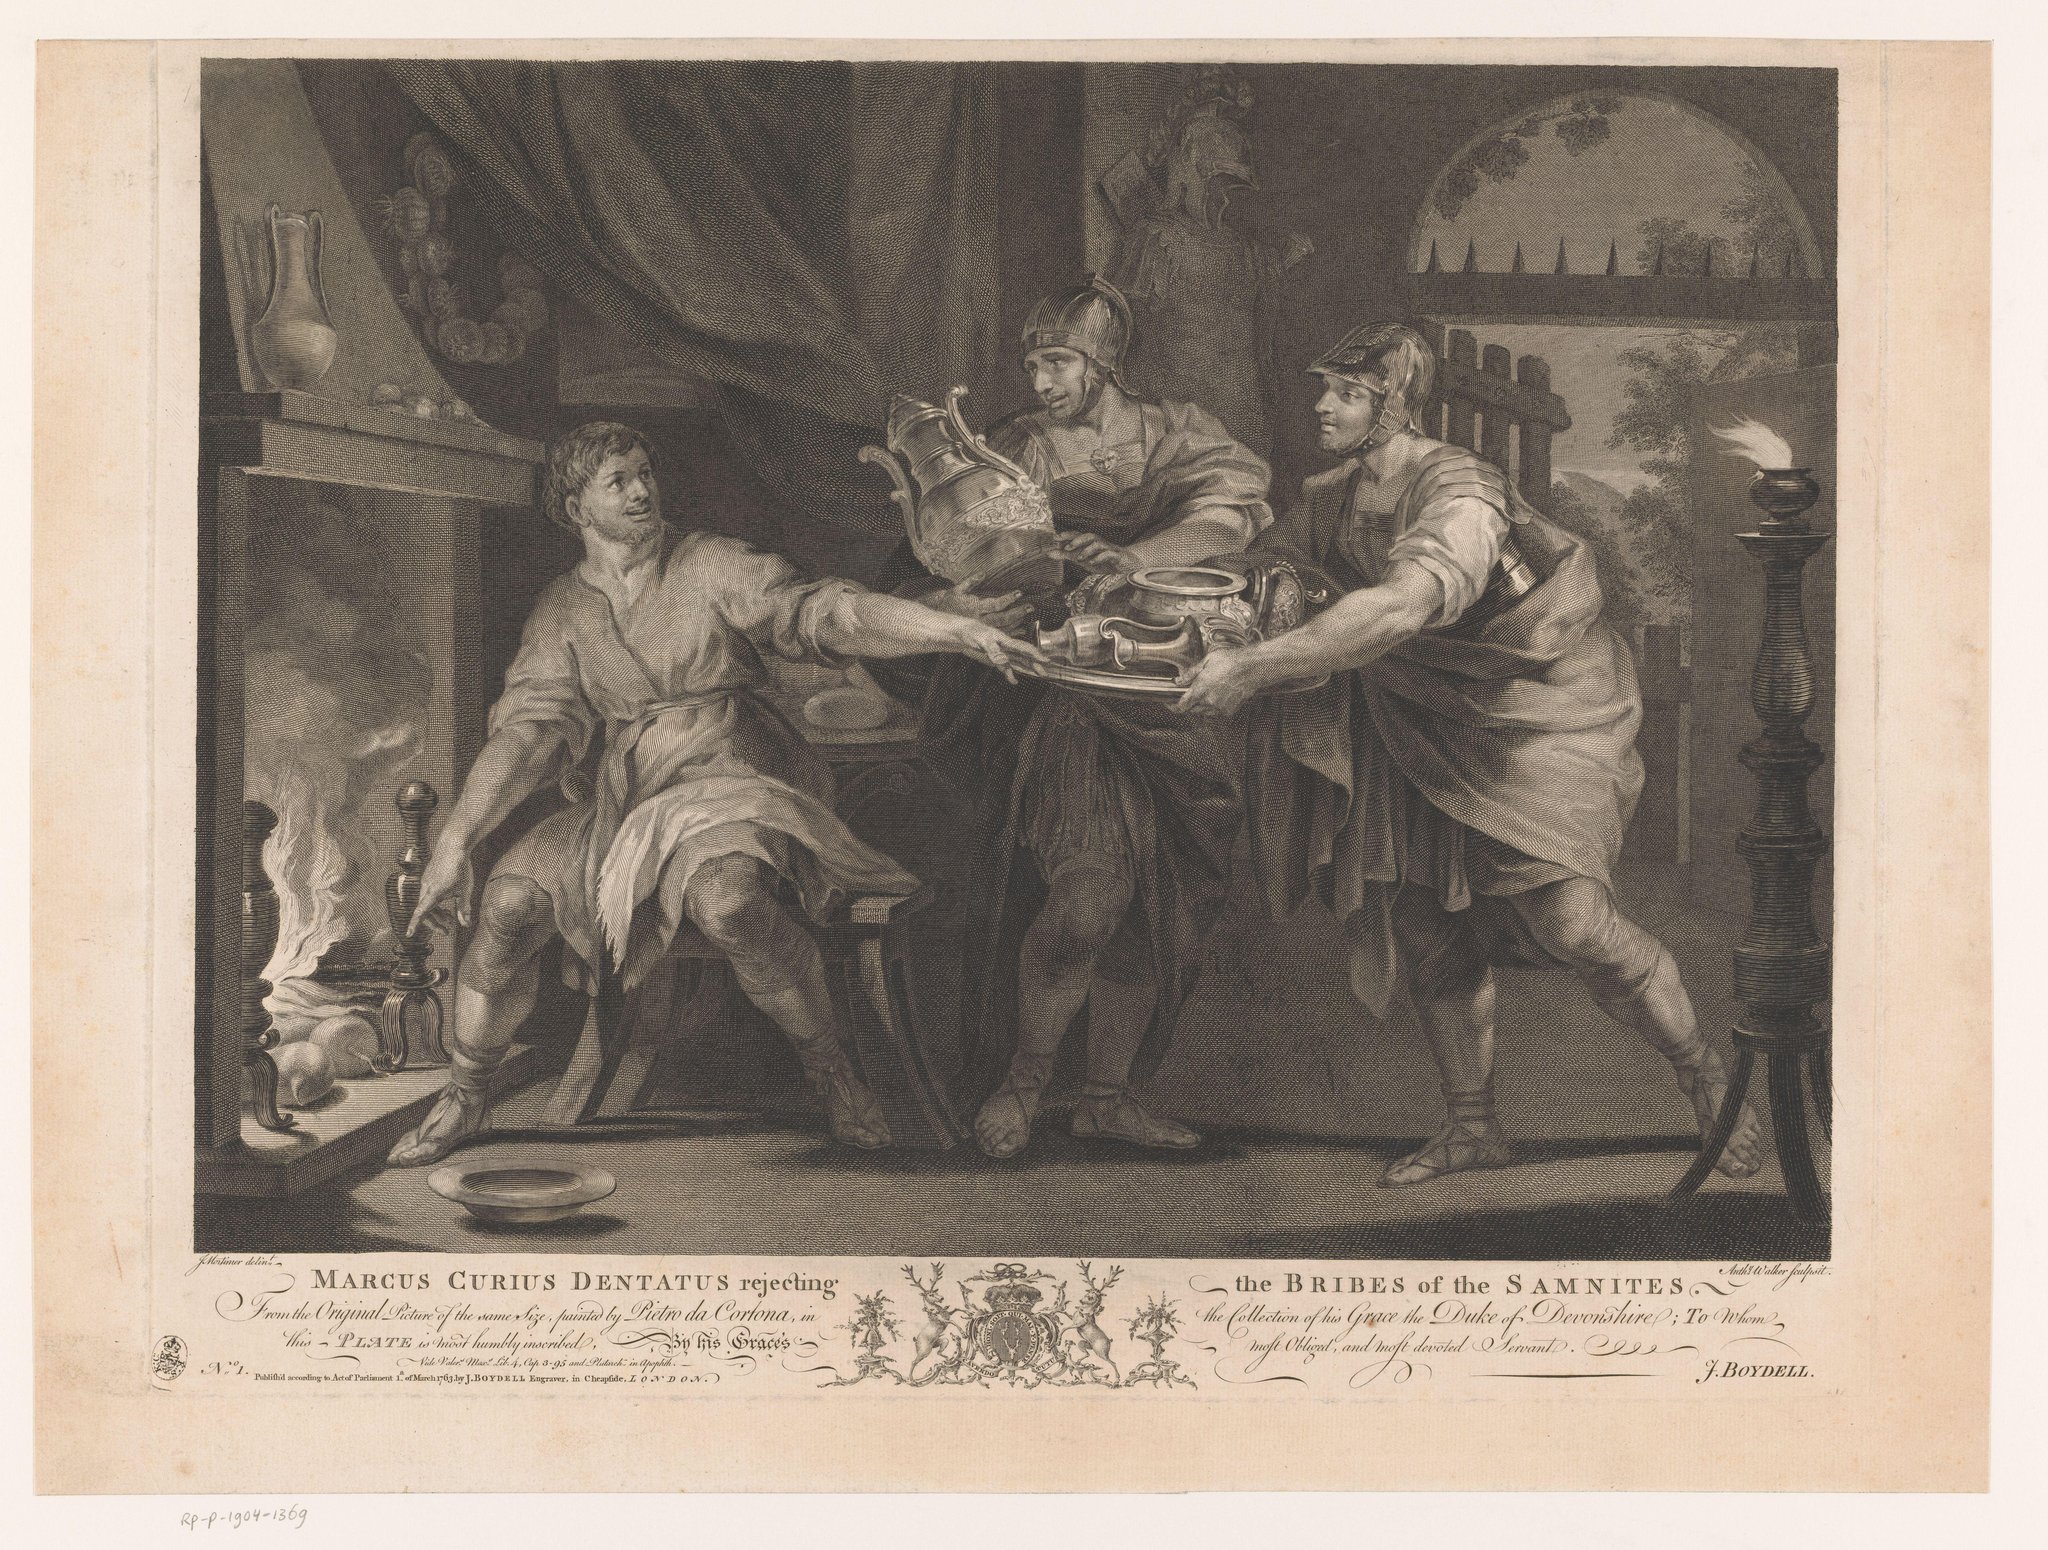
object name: print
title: Zeventiende-eeuwse schilderijen uit de Devonshire-collectie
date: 1703-1763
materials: paper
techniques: etching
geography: london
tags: bribery, manius curius dentatus, while cooking a simple meal at his hearth, refuses the gifts of the samnites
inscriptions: collector's mark: Lugt 1618, collector's mark: Lugt 2228, collector's mark: Lugt 1647